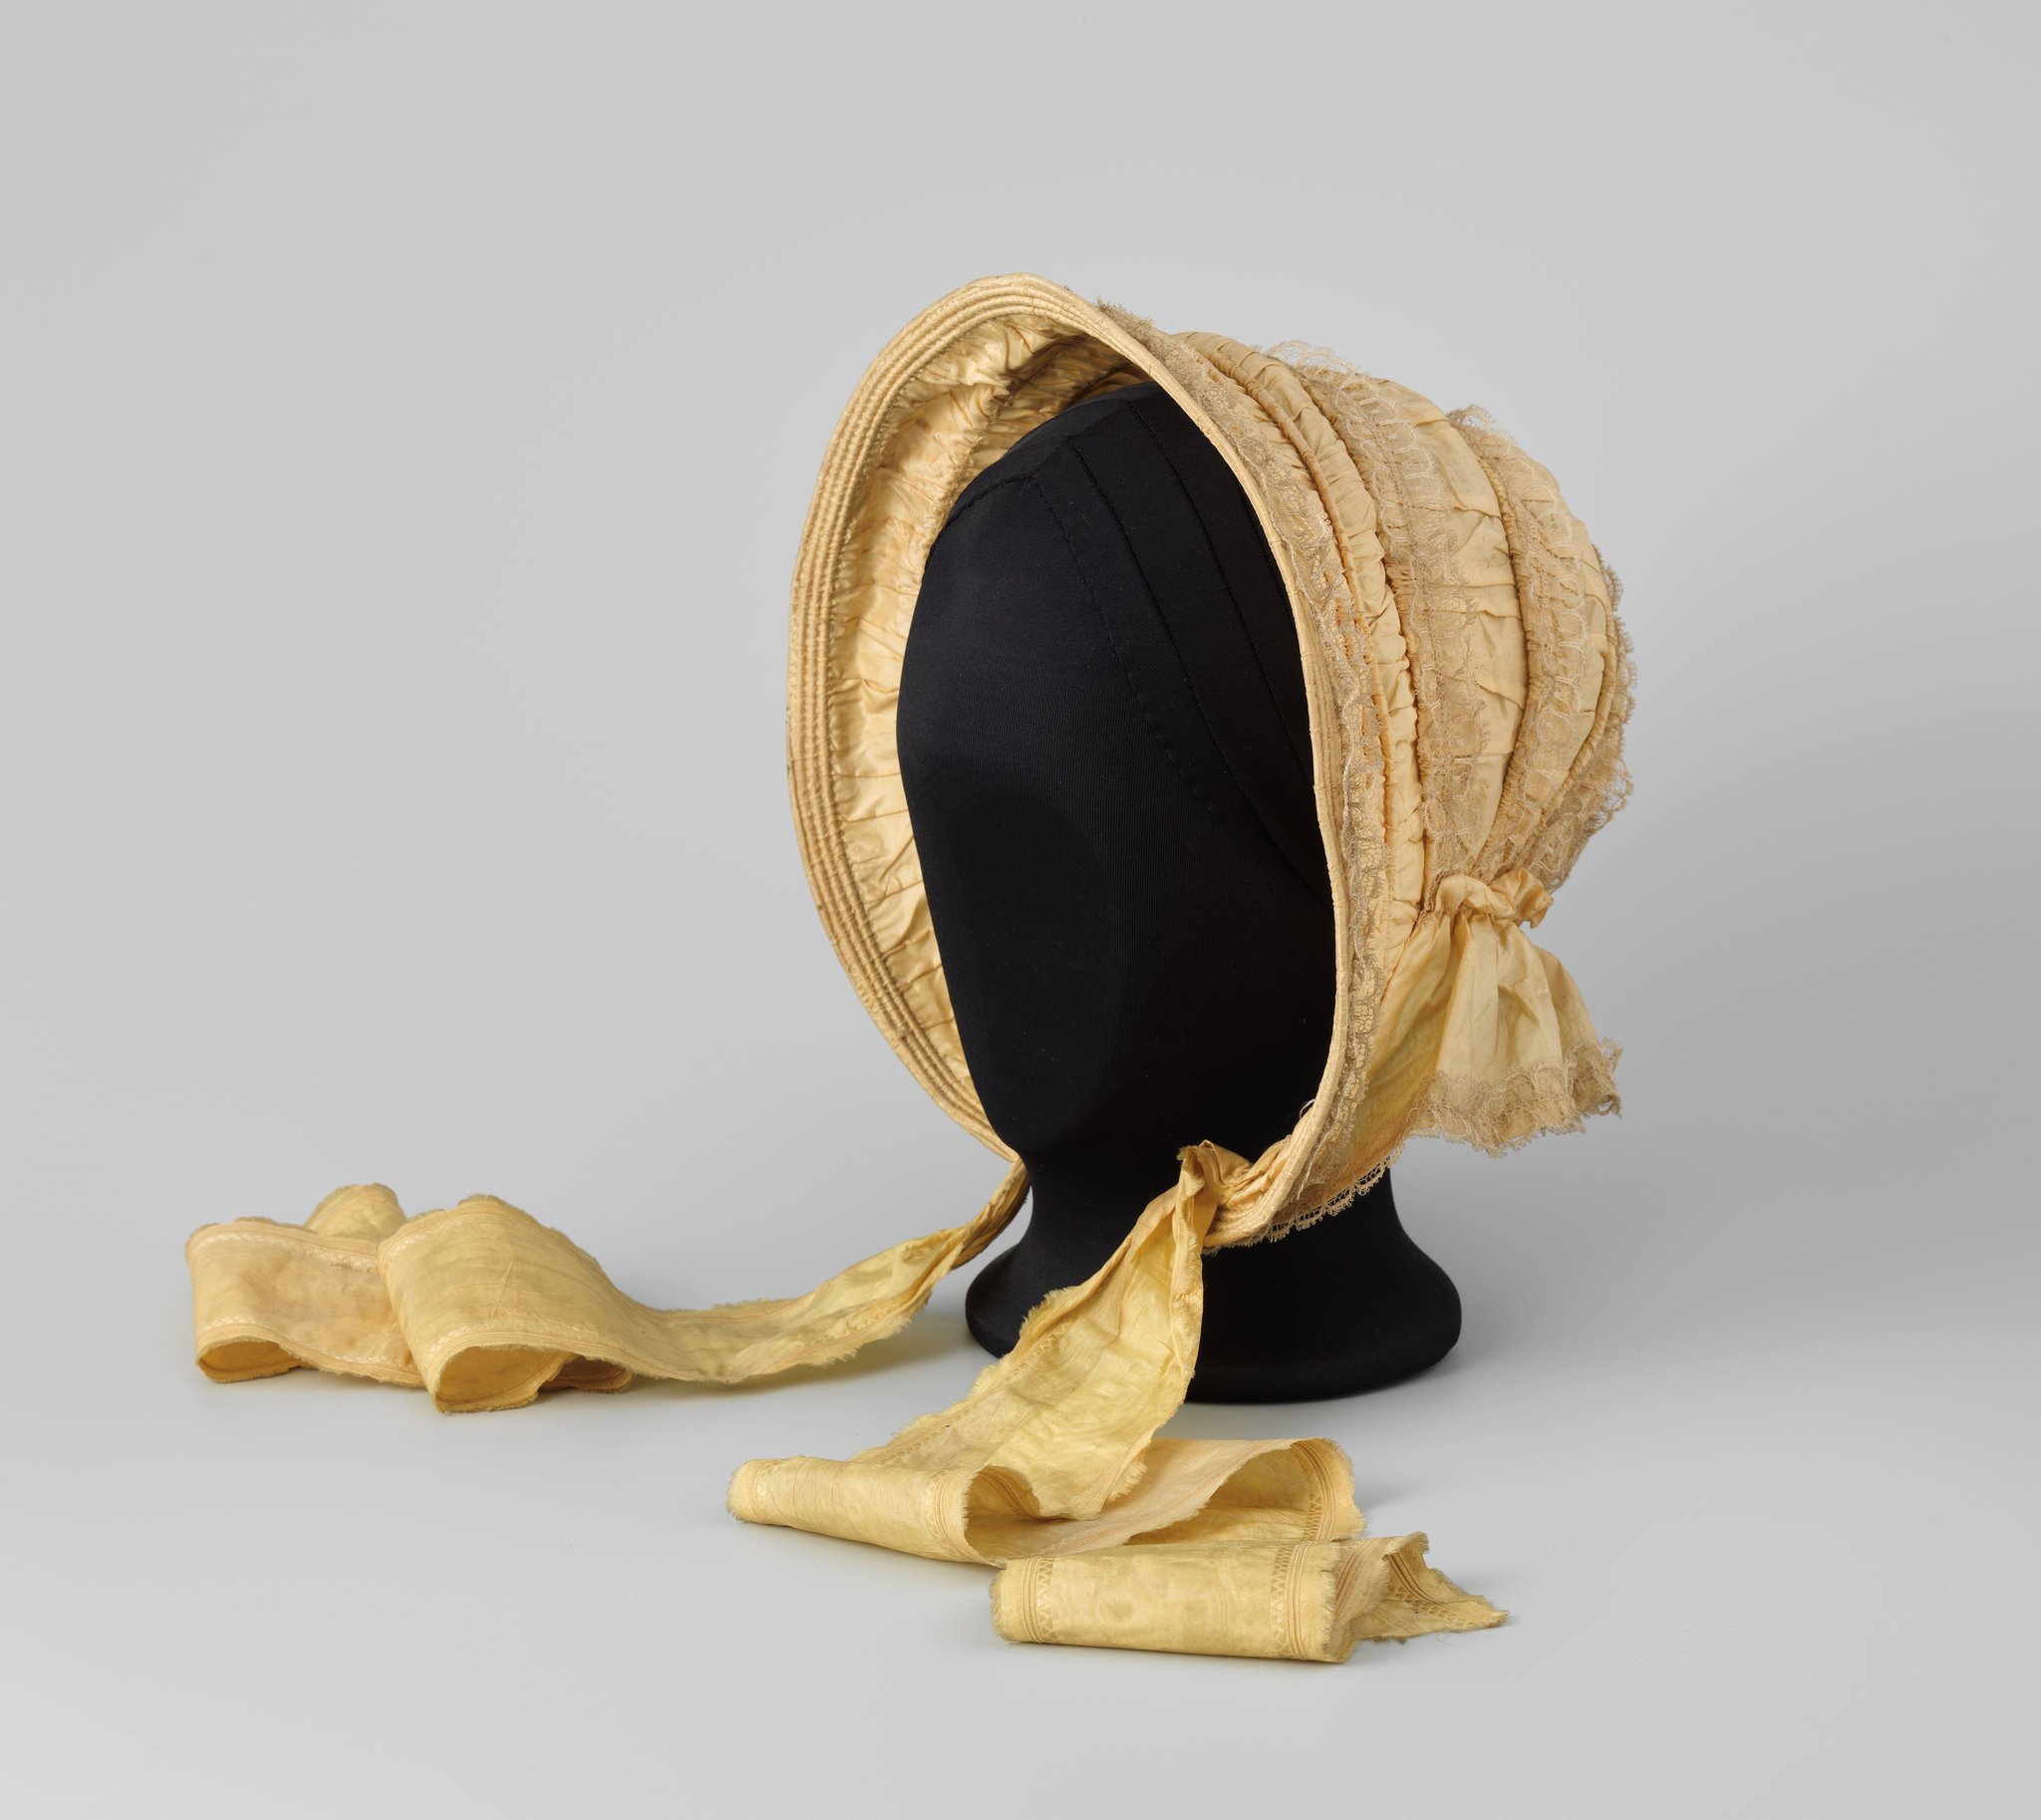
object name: bonnet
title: Luifelhoed van gele tafzijde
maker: Anonymous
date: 1845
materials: silk, textile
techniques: lace, moire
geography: western europe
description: Luifelhoed van gele tafzijde, versierd met wit kant, kleurige zijde 'Blonde'. Halfronde bol laag tegen achterhoofd gedragen, gerimpelde strook in de nek, 'bavolette'. In de bol vier, in de luifel drie hoepeltjes. Twee gele moiré-linten.